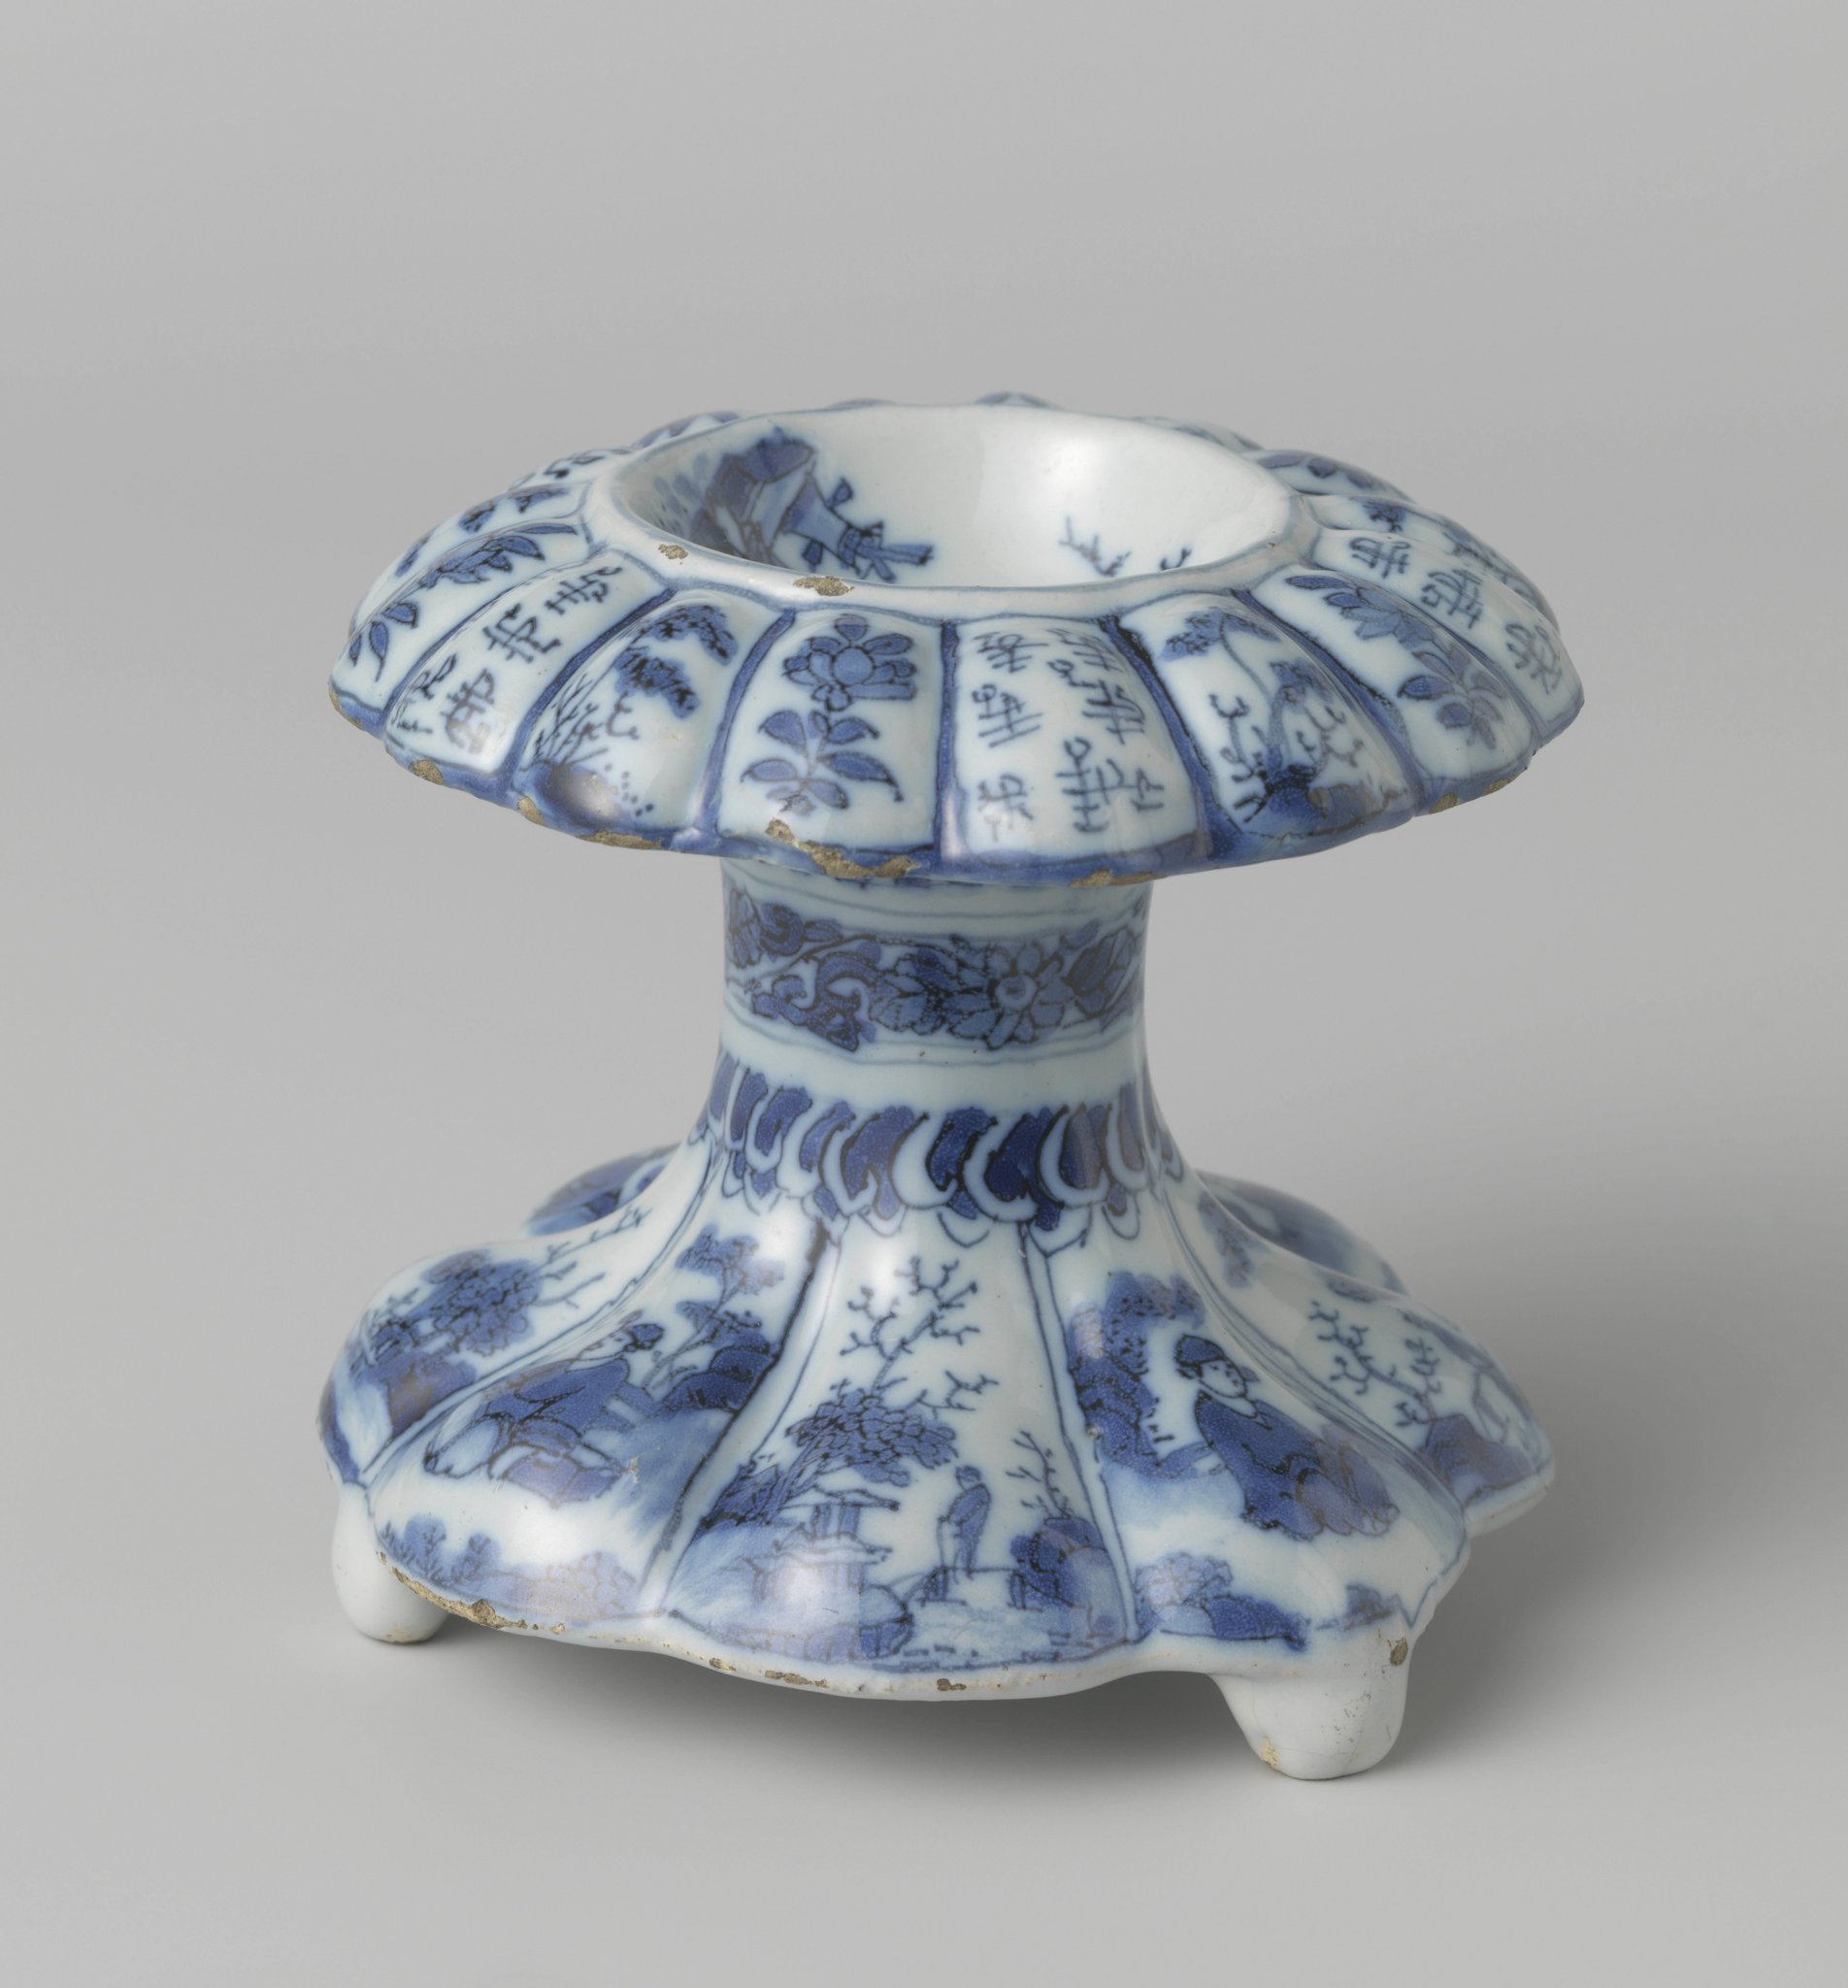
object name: salt condiment vessel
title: Salt cellar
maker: samuel van eenhoorn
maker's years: 1655-1687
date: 1680-1690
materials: earthenware, glaze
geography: delft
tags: chinese (+ other cultural aspects), flowers ~ ornament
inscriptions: mark: ‘SVE(ineen)/ 3’